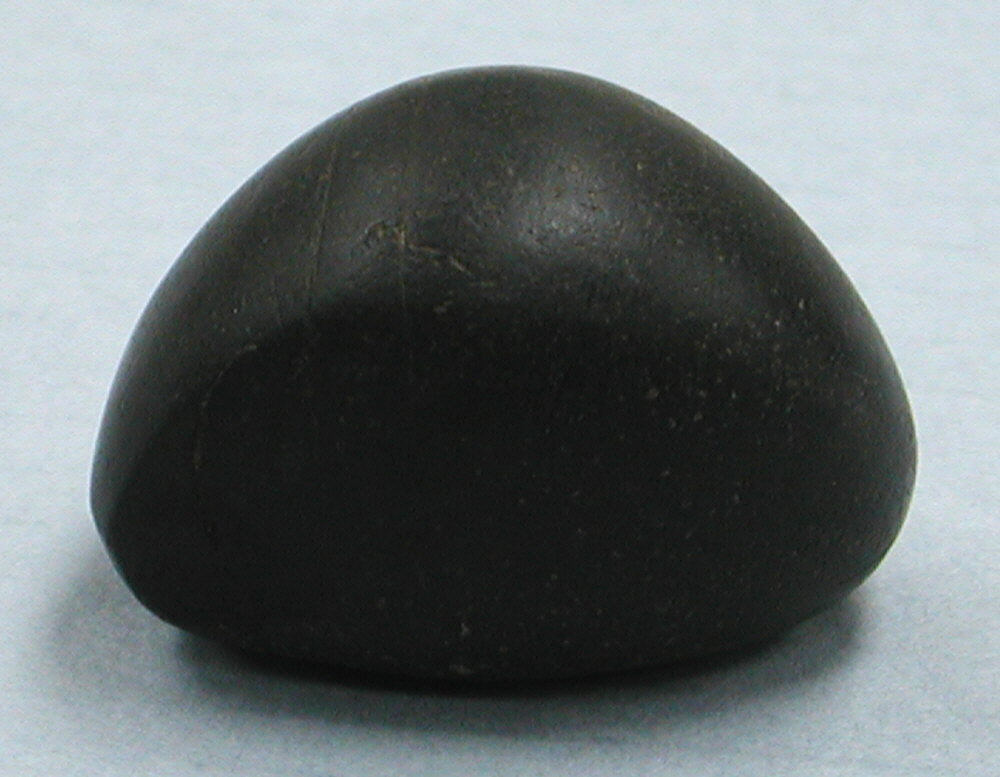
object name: ritual stone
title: Stone Pulidor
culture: mexican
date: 1501-1600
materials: stone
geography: mexico